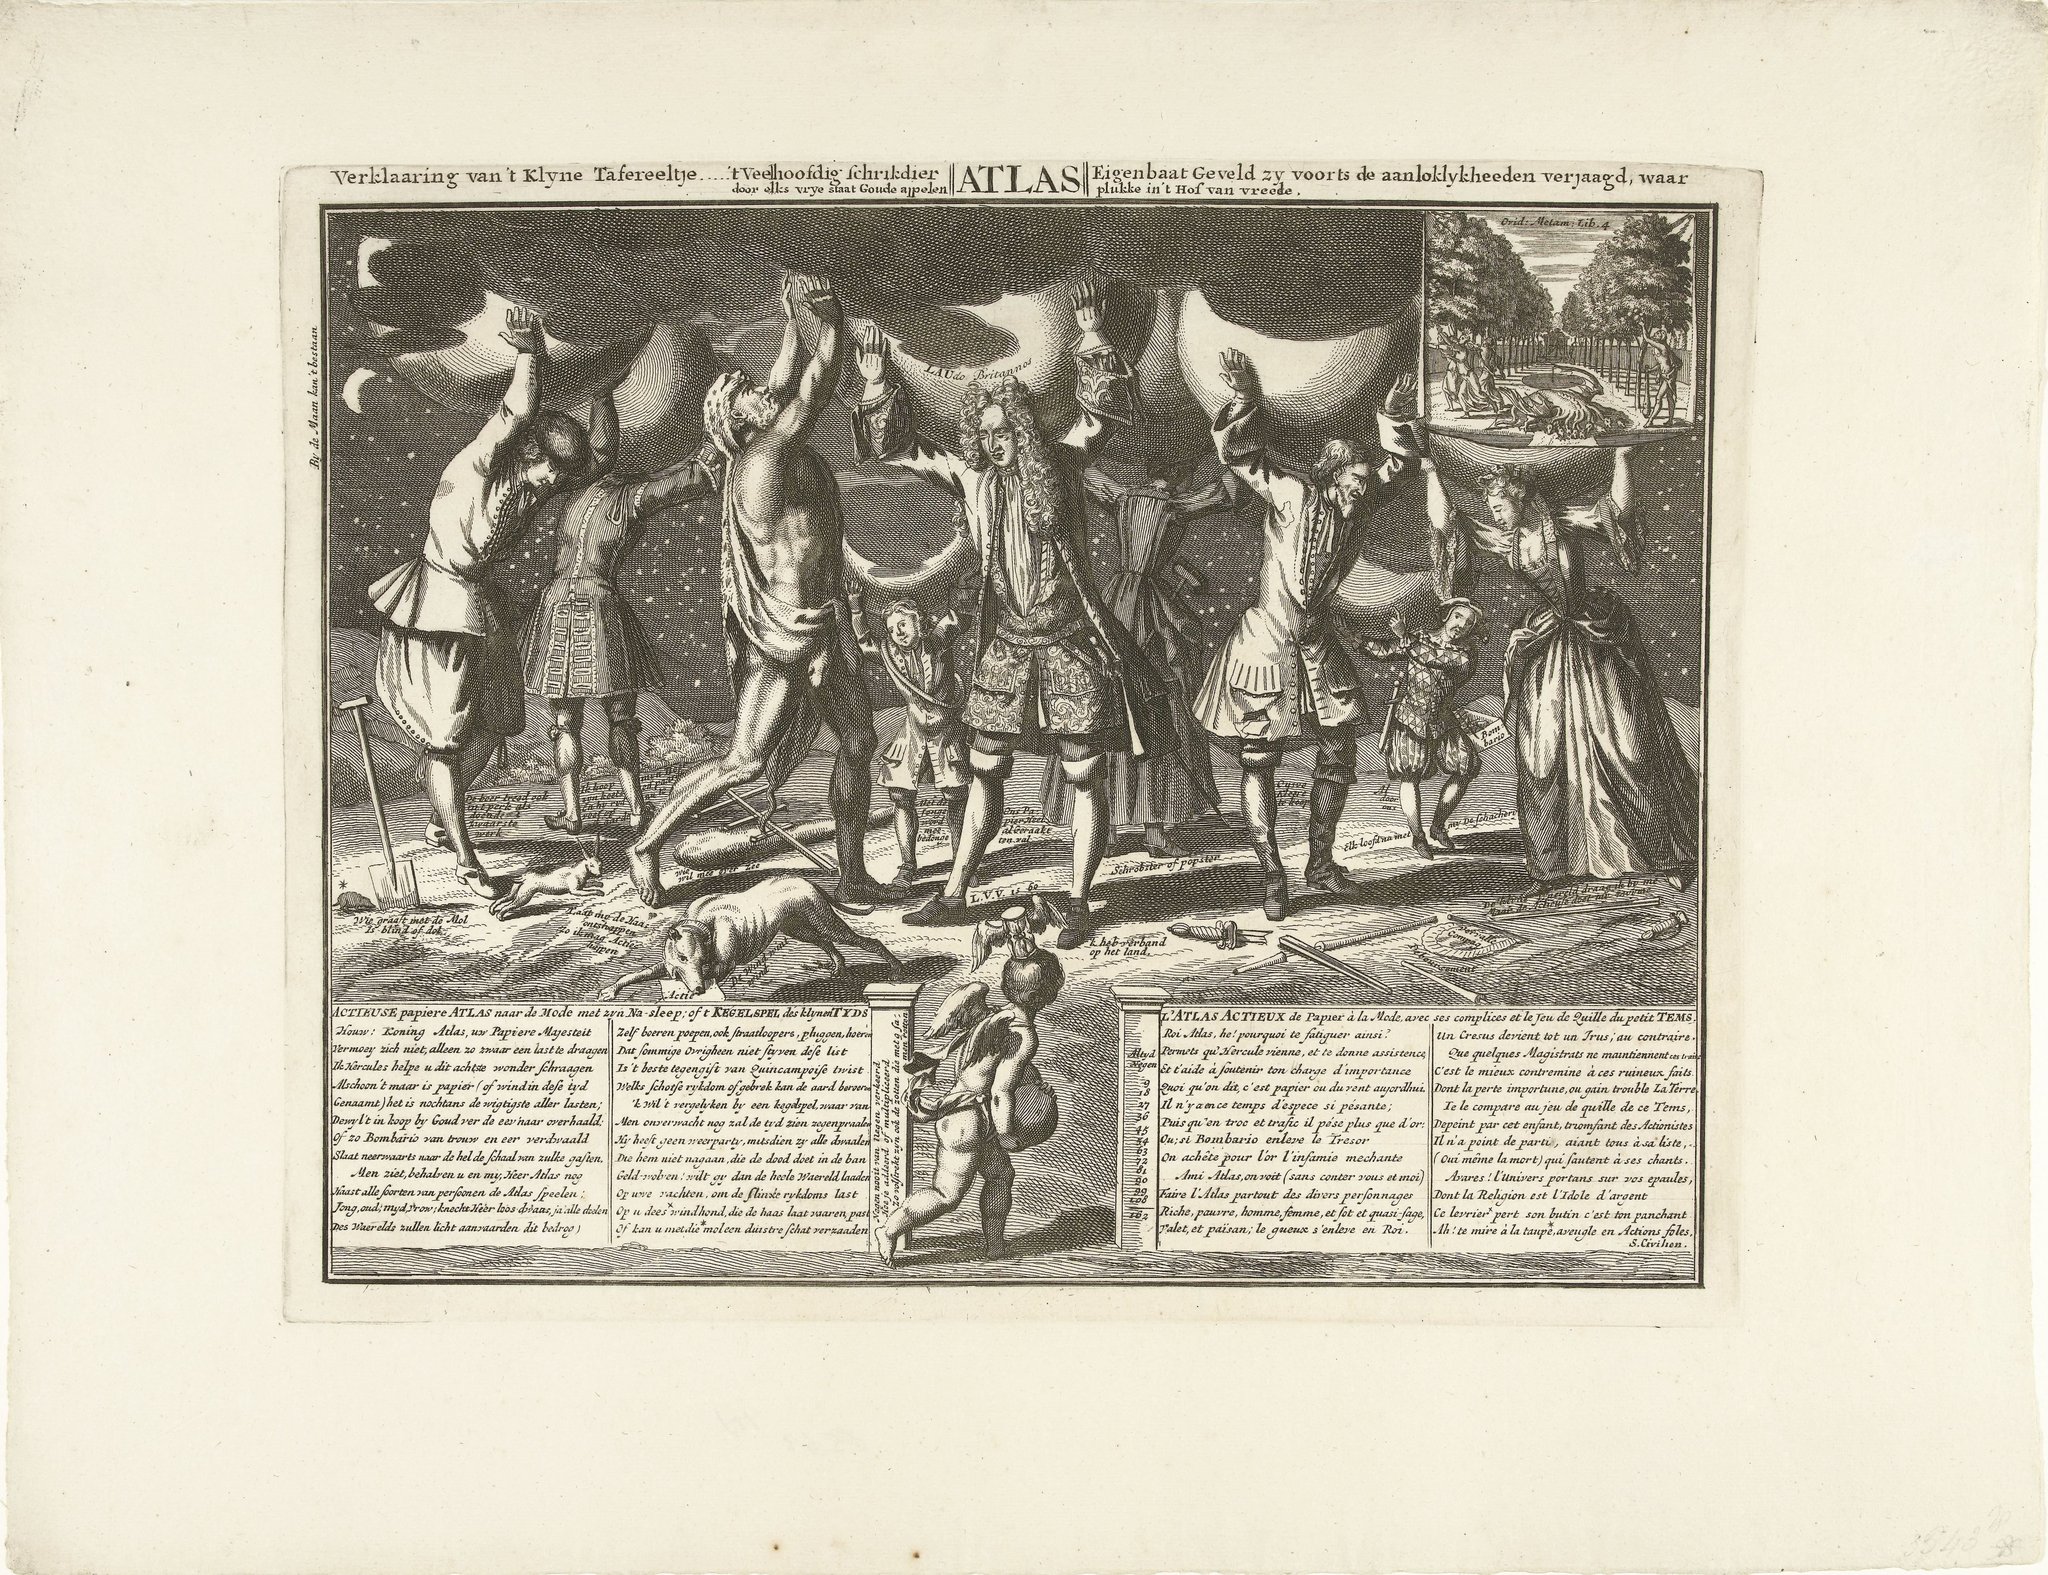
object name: cartoon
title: Actieuse papiere Atlas naar de Mode met zyn Na-sleep; of t Kegelspel des klynenTypds / L'Atlas Actieux de Papier à la Mode (...)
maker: Anonymous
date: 1720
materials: paper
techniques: etching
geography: northern netherlands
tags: atlas supporting the heavens on his shoulders, bowling games (children's games)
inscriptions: collector's mark: Lugt 2228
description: John Law en andere mannen en vrouwen torsen gelijk Atlas hun schulden als een enorme bol (met wind of papier) op hun schouders. Op de voorgrond staat de tijd klaar om met een bal de personen omver te kegelen. Met onderschriften in het Nederlands en Frans door S. Civilien. Prent 8 in de serie Het Groote Tafereel der Dwaasheid met spotprenten op de Windhandel of Actiehandel van 1720.